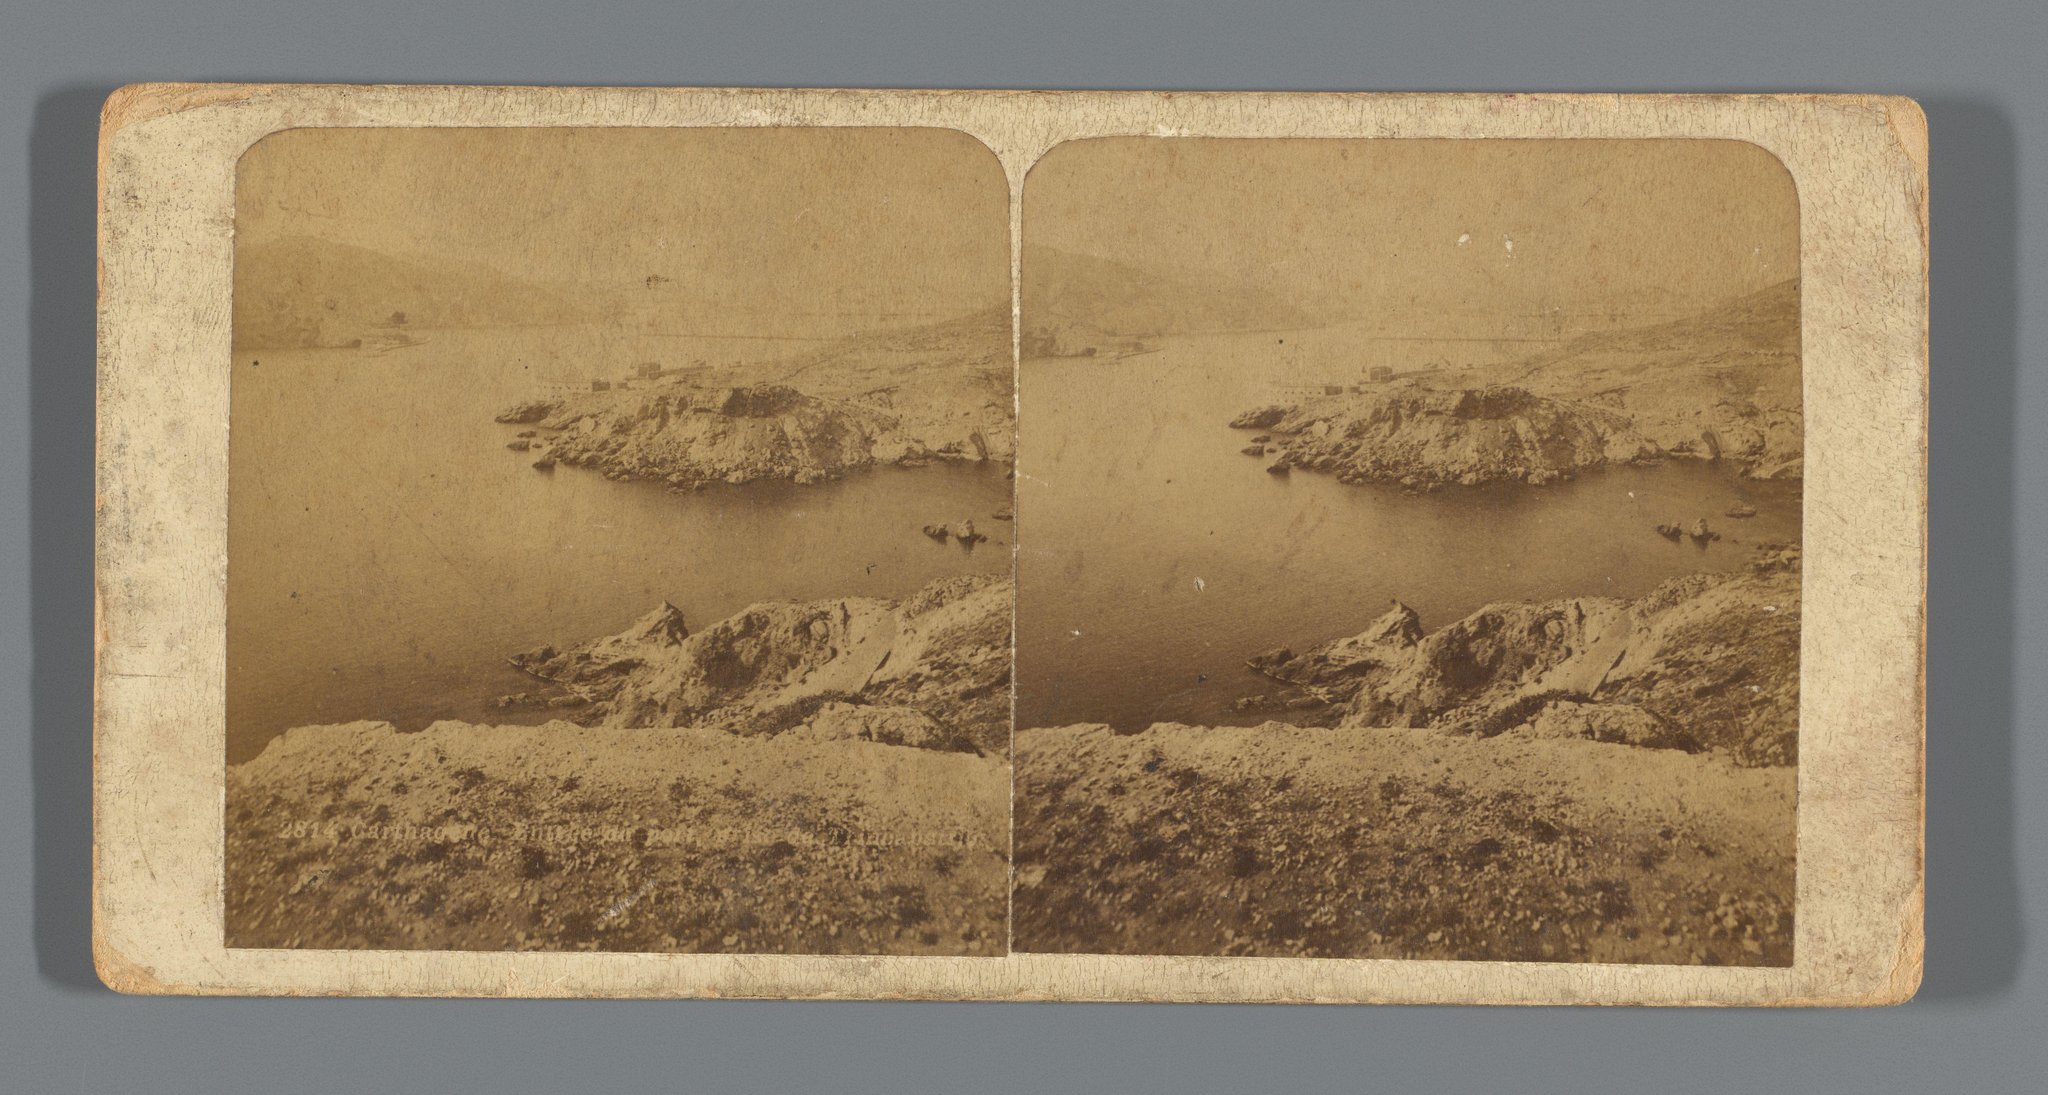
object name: stereograph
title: Aardrijkskundige Beeldengalerij, verzameld door M.J. Broekhuijsen, Hoofd eener school te Amsterdam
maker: martien johan broekhuijsen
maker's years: 1871-1956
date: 1905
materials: photographic support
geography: amsterdam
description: Onderdeel van een groep van 52 stereofoto's gebruikt in het lager onderwijs als aanvulling op schoolplaten. De gehele reeks bestond uit 274 nummers in 10 categorieën (A t/m K).